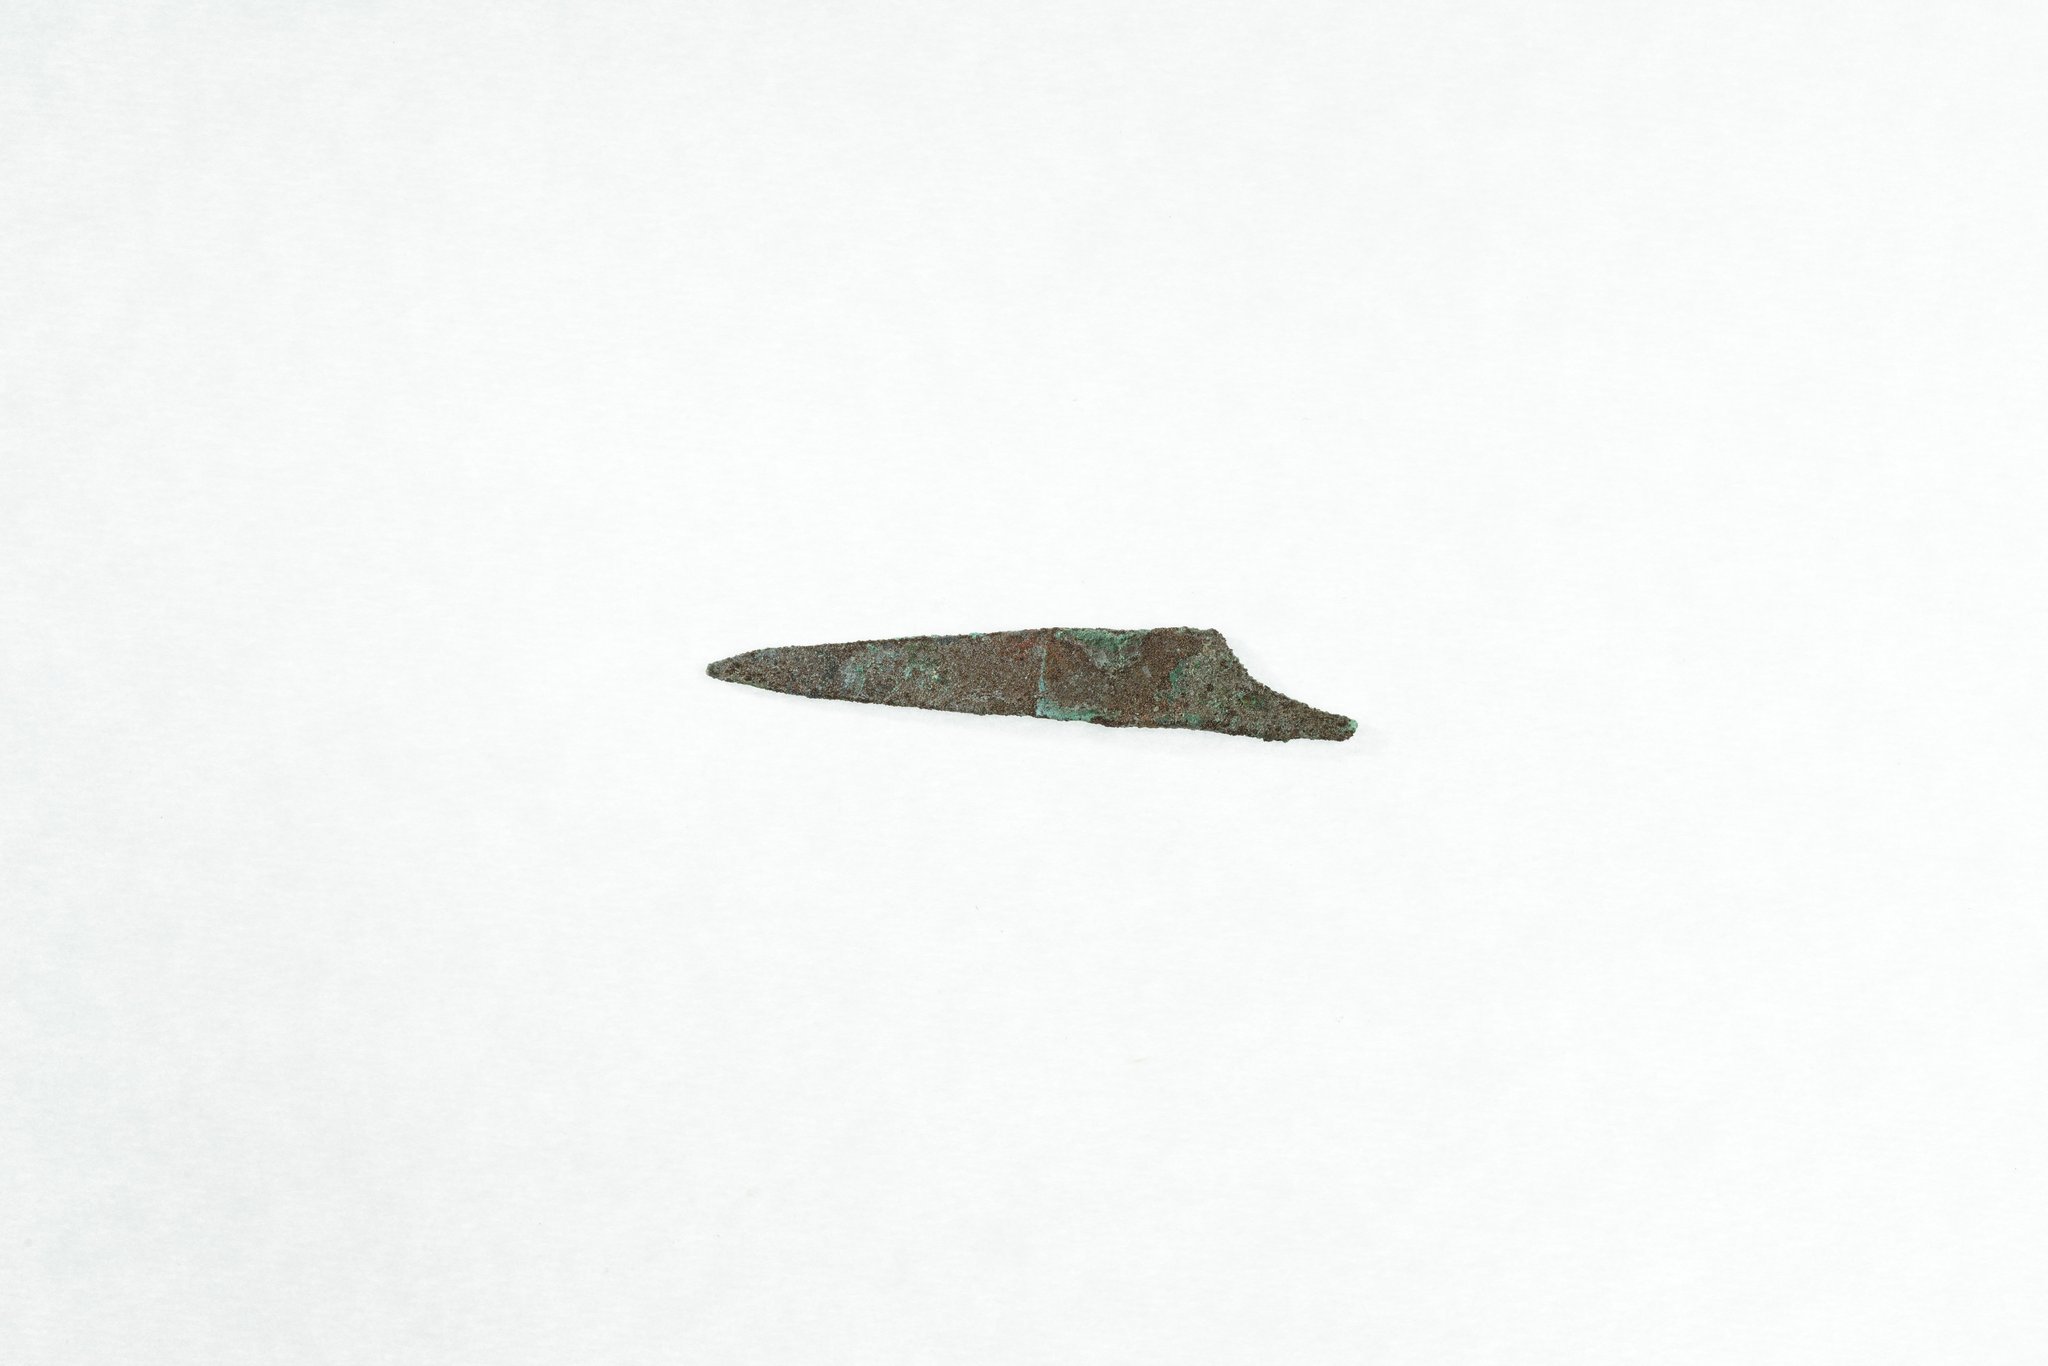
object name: saw, model, tool, senenmut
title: Blade for a Model Saw from a Foundation Deposit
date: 1479-1458 BCE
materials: bronze, copper alloy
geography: egypt